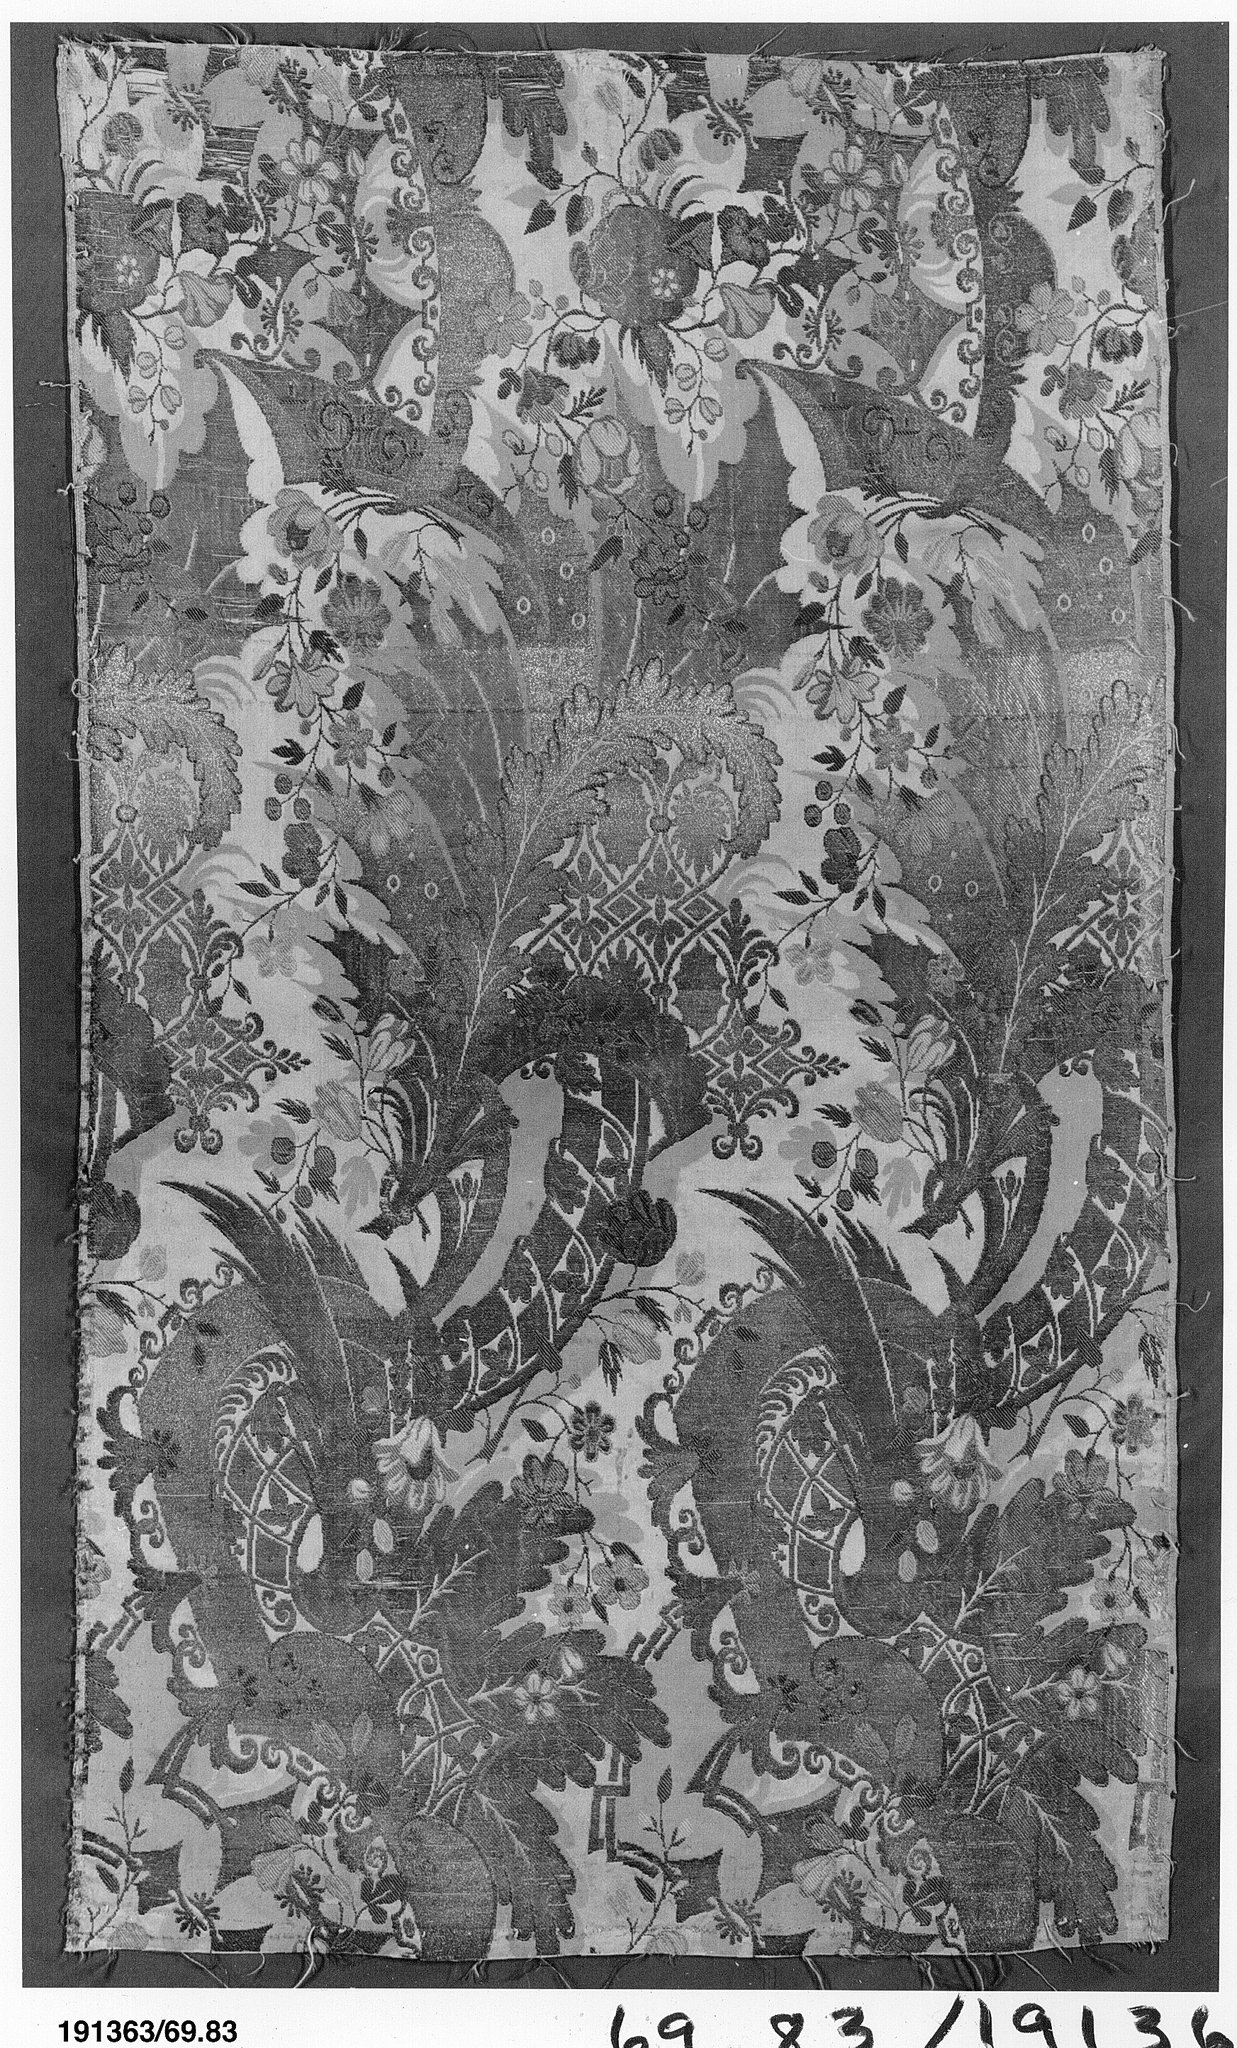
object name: length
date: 1701-1733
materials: metal thread, silk